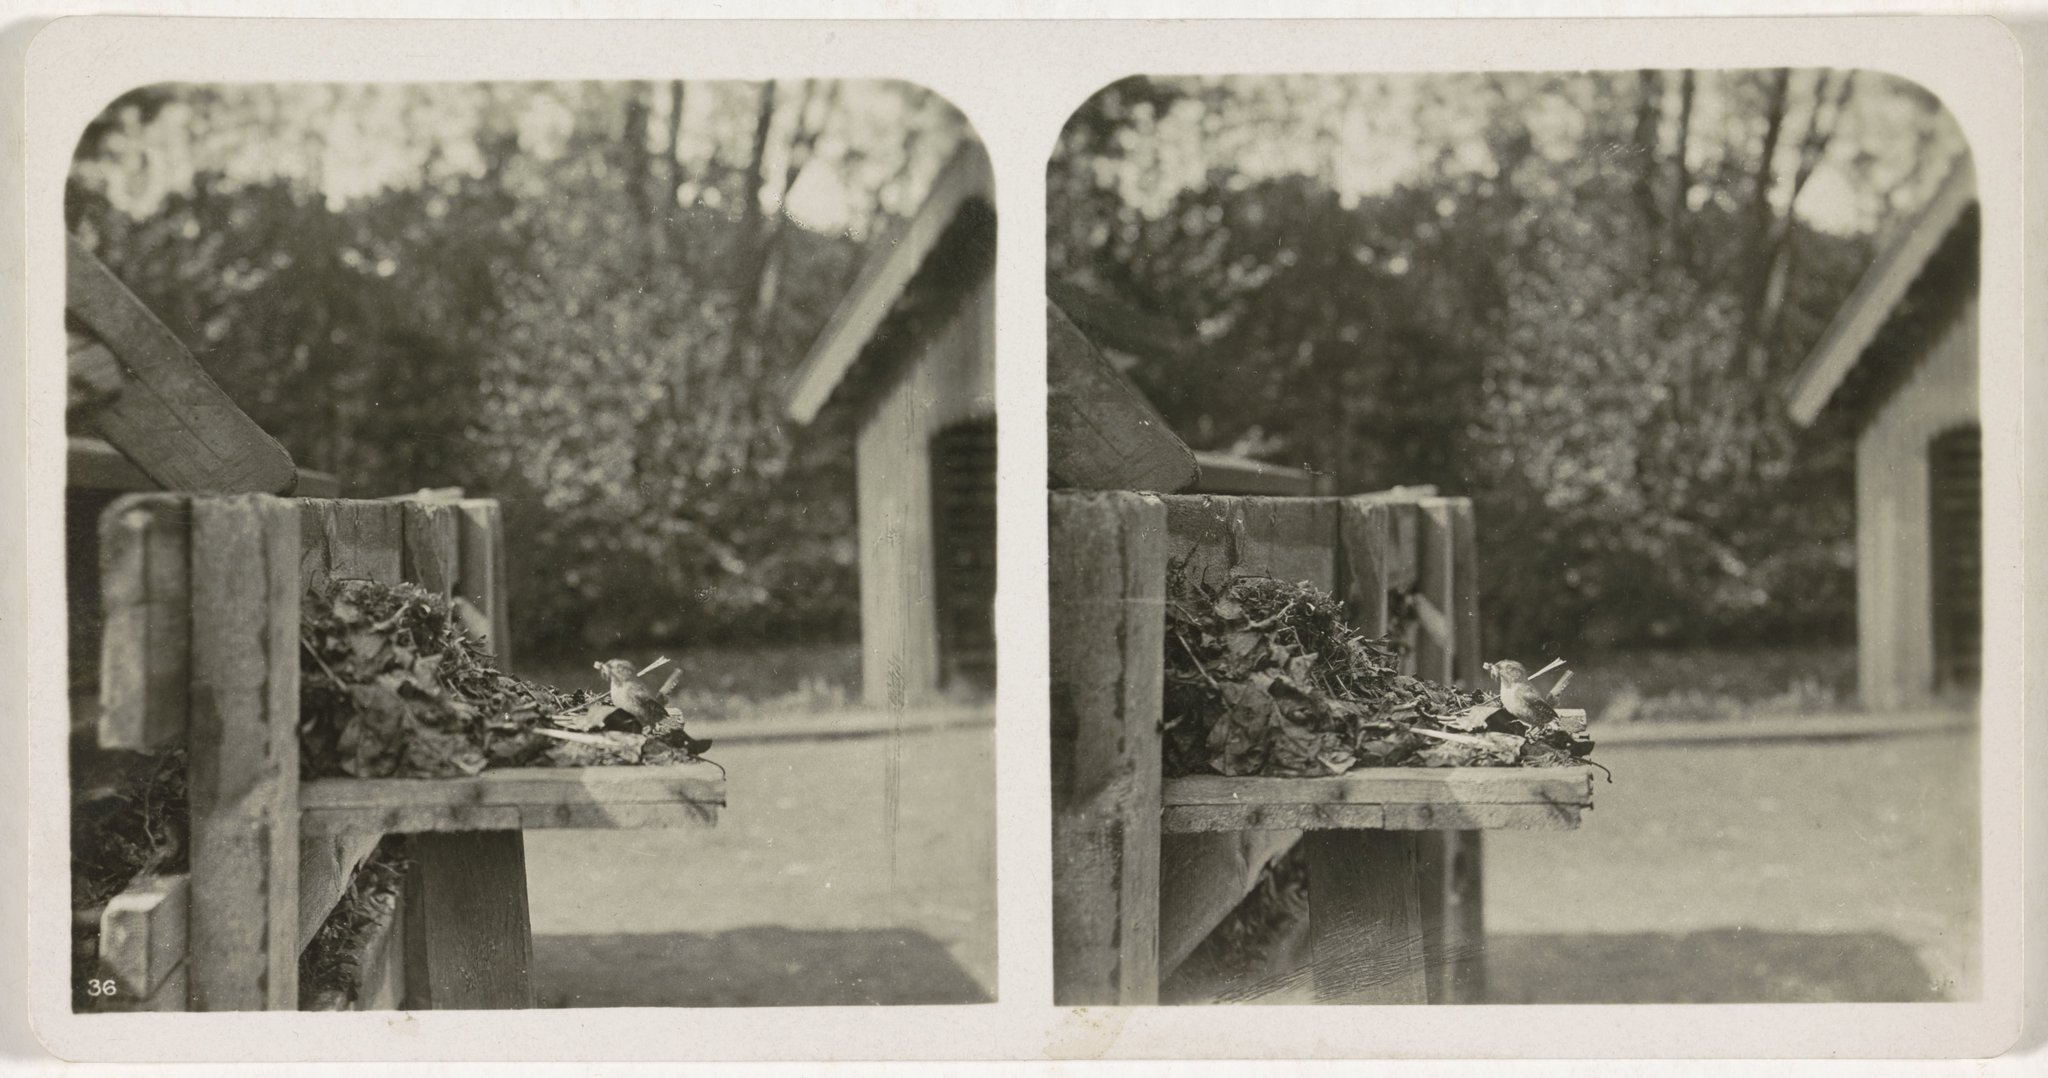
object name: stereograph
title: Winterkoninkje bij nest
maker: adolphe burdet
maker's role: fotograaf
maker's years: 1860-1940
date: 1870-1940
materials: photographic support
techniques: gelatin silver print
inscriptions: label: ‘36 / Troglodytes parvulus Koch / Troglodyte / Winterkoning...’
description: Linksonder op de foto links staat het nummer 36. Uit serie van 25 stereofoto's.